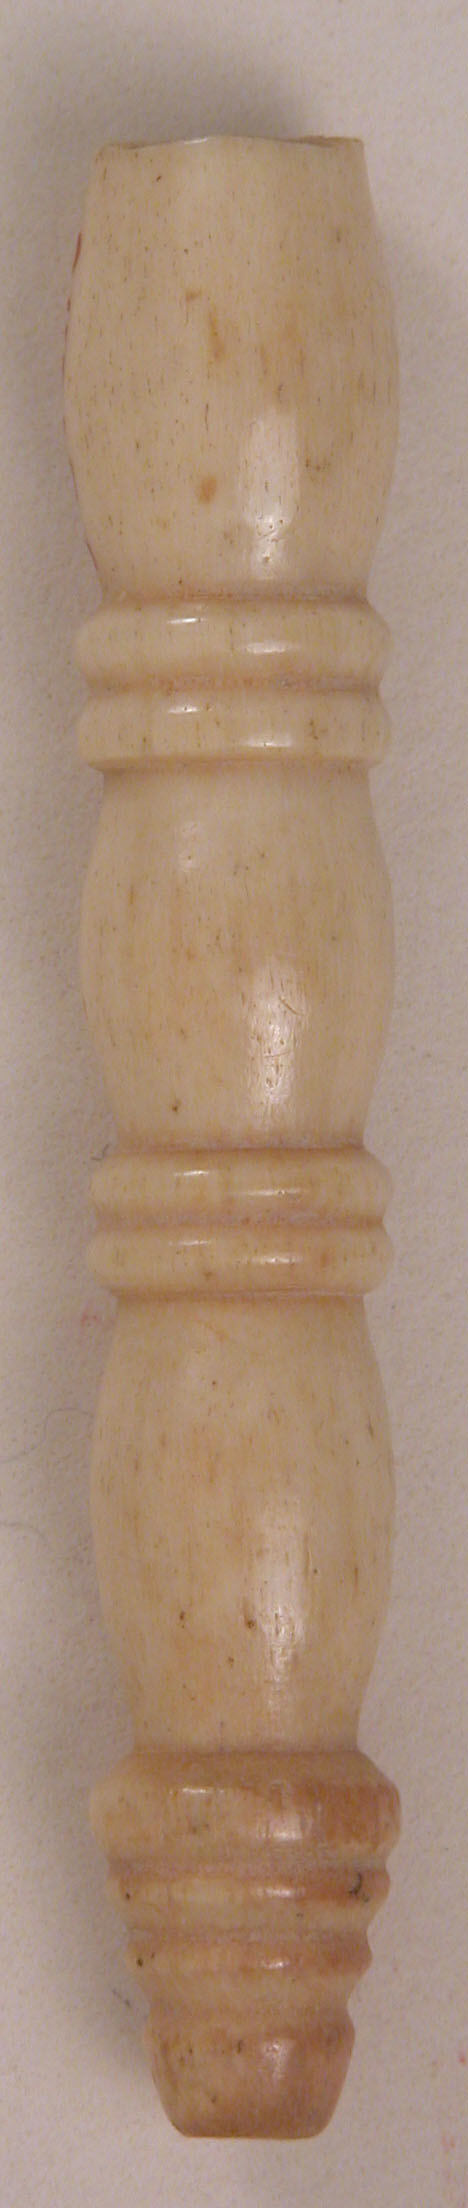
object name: rod or bobbin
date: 401-800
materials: bone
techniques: carving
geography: palestine